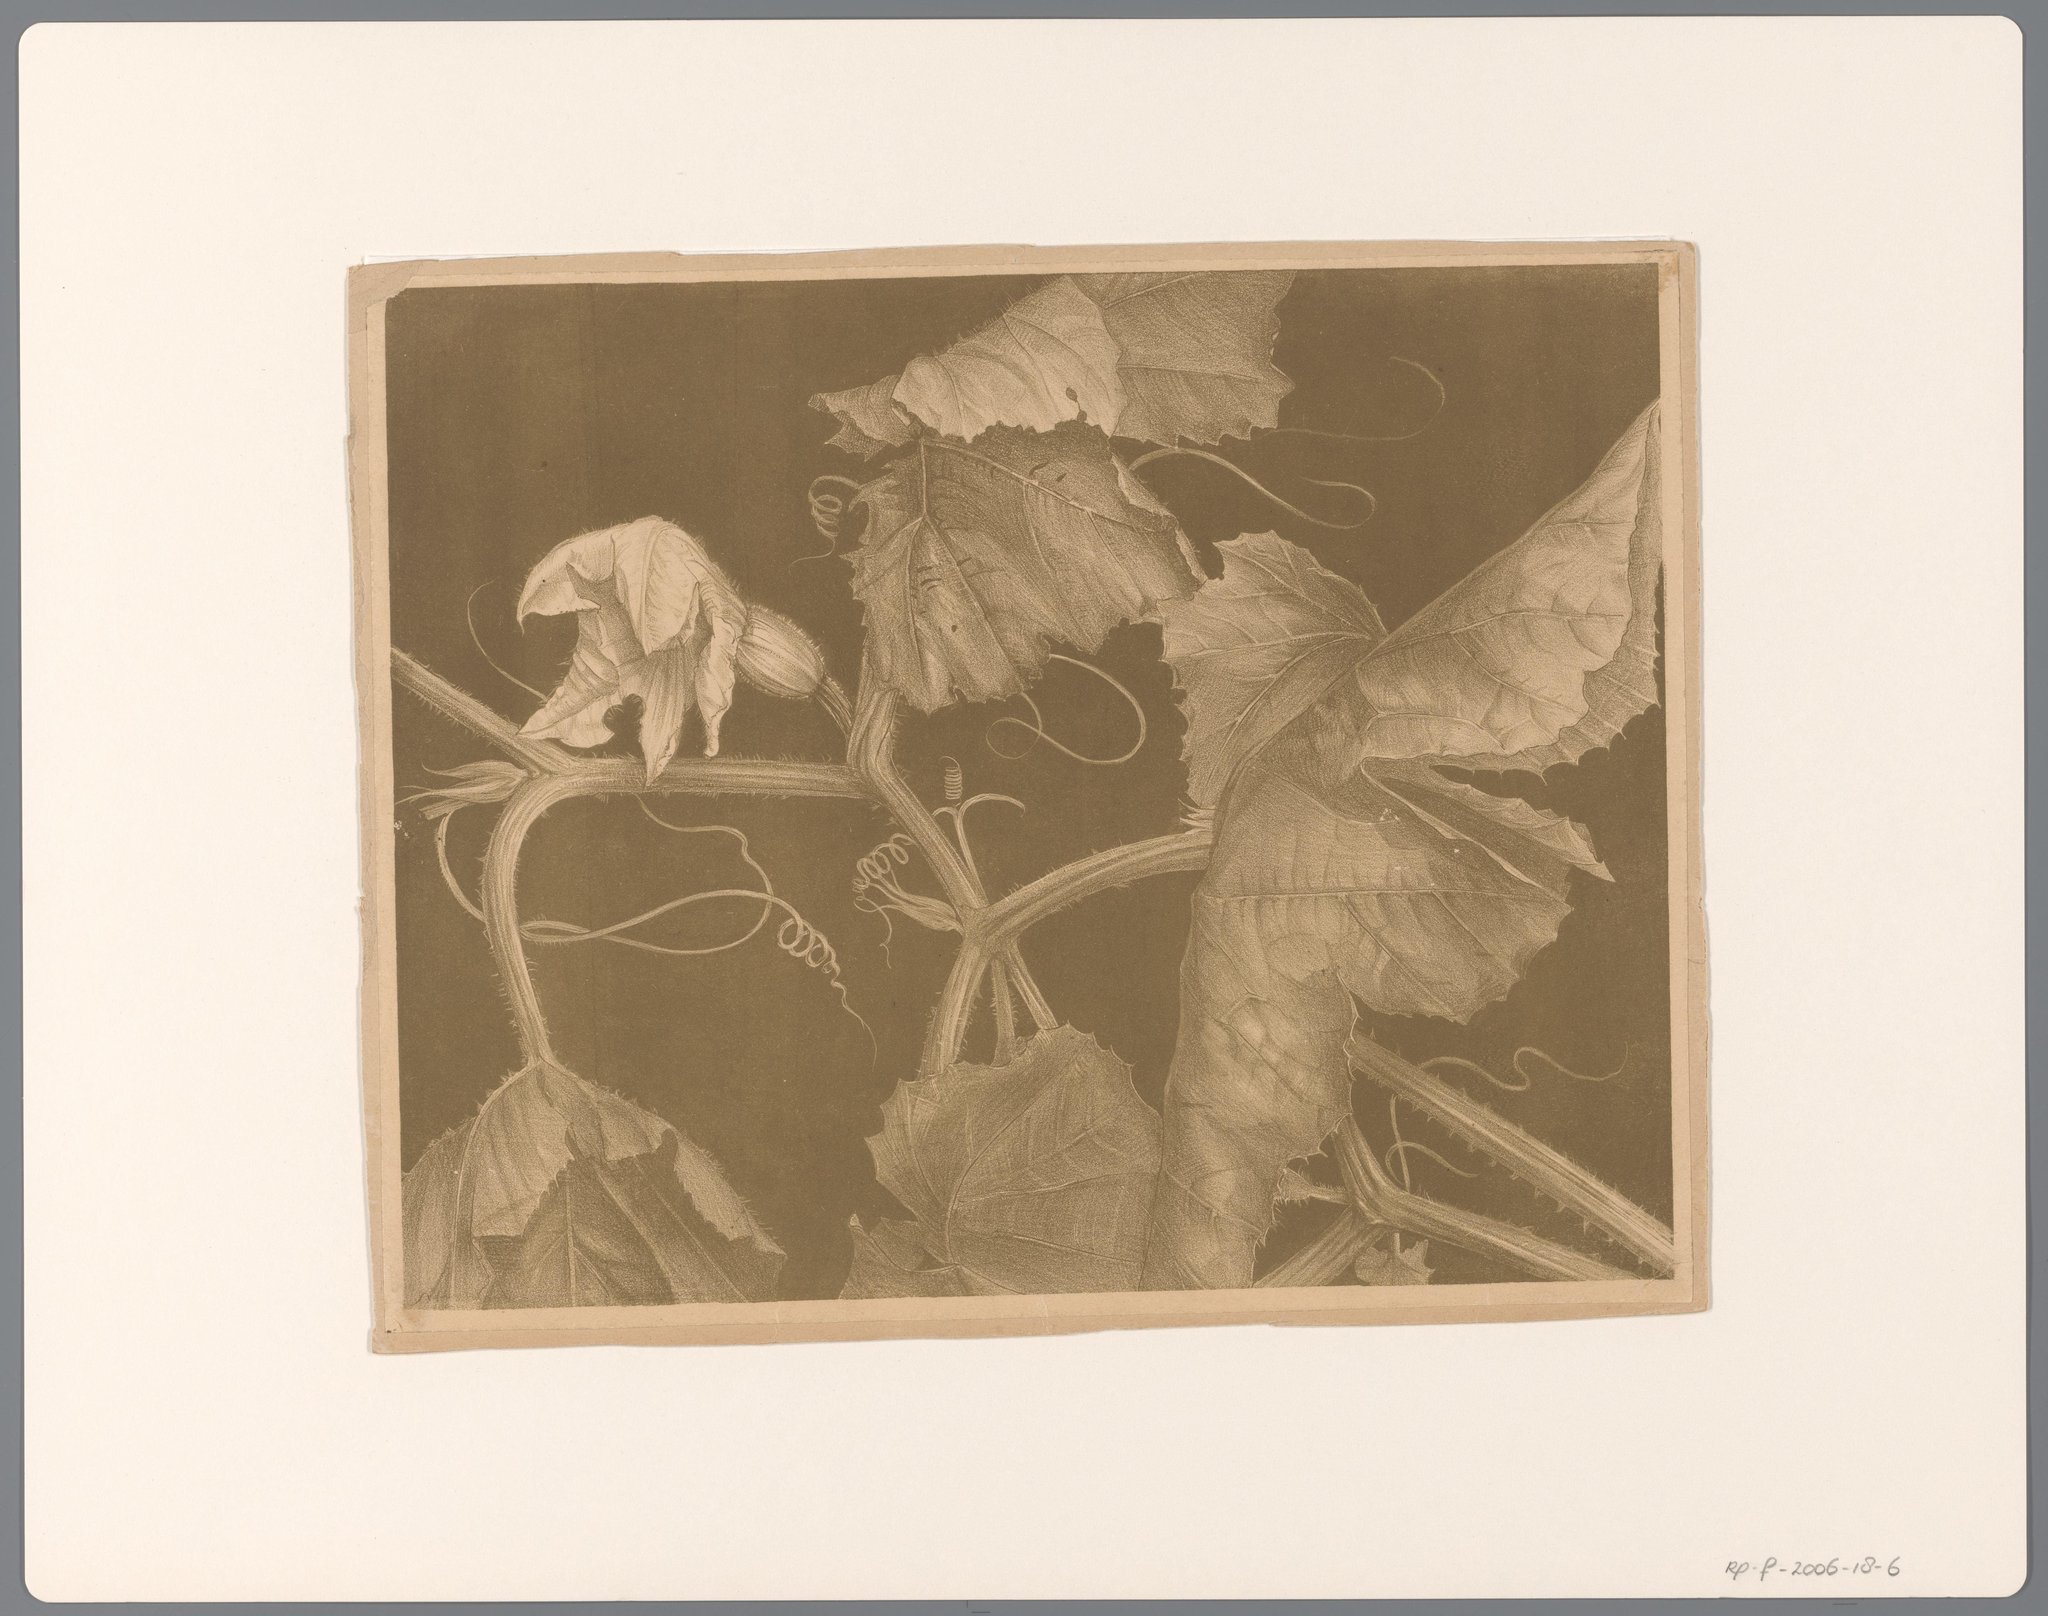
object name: print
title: Tak met knop uit de komkommerfamilie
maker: Anonymous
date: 1800-1900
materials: cardboard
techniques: lithograph